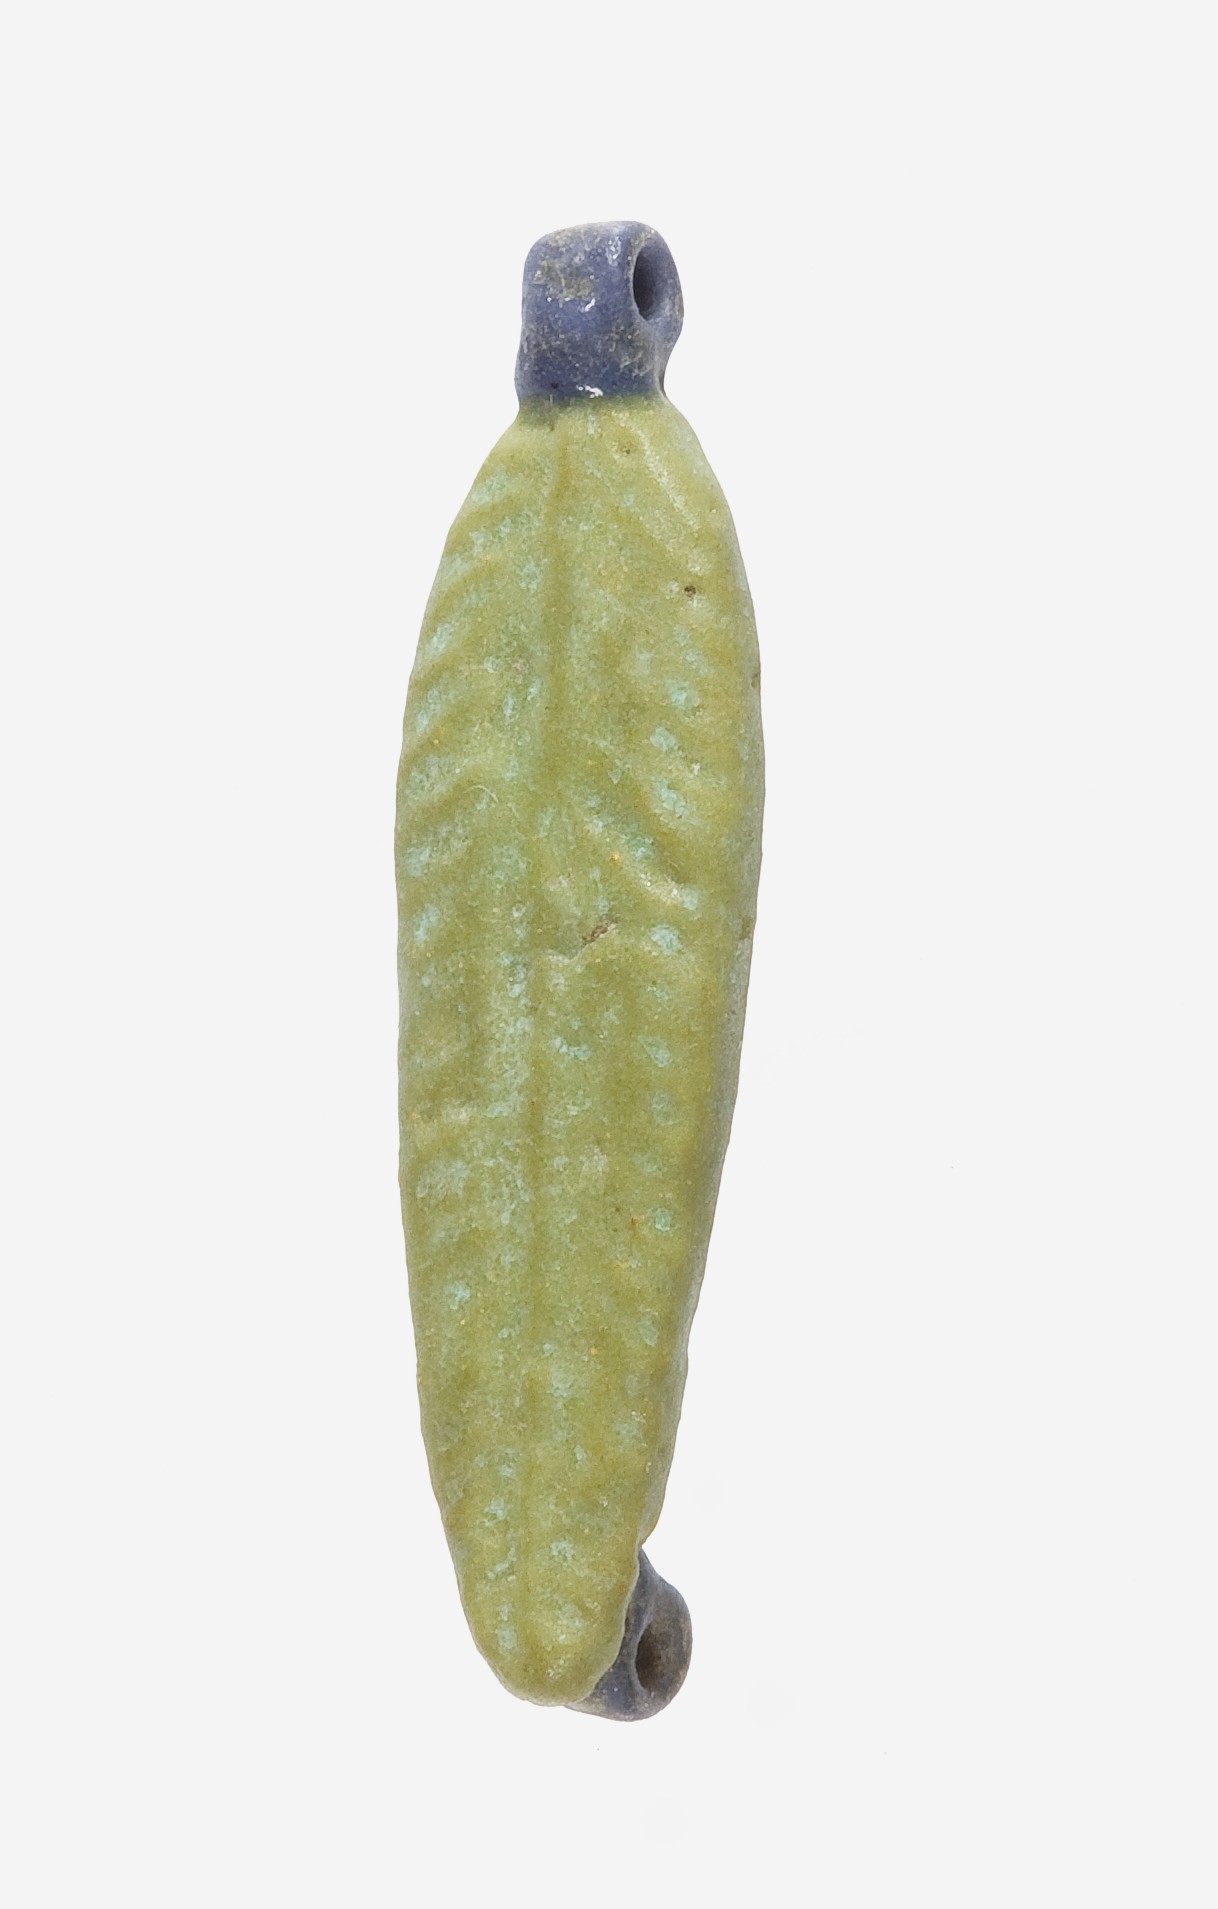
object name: pendant, leaf petal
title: Leaf Pendant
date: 1390-1352 BCE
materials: faience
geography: egypt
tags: leaves